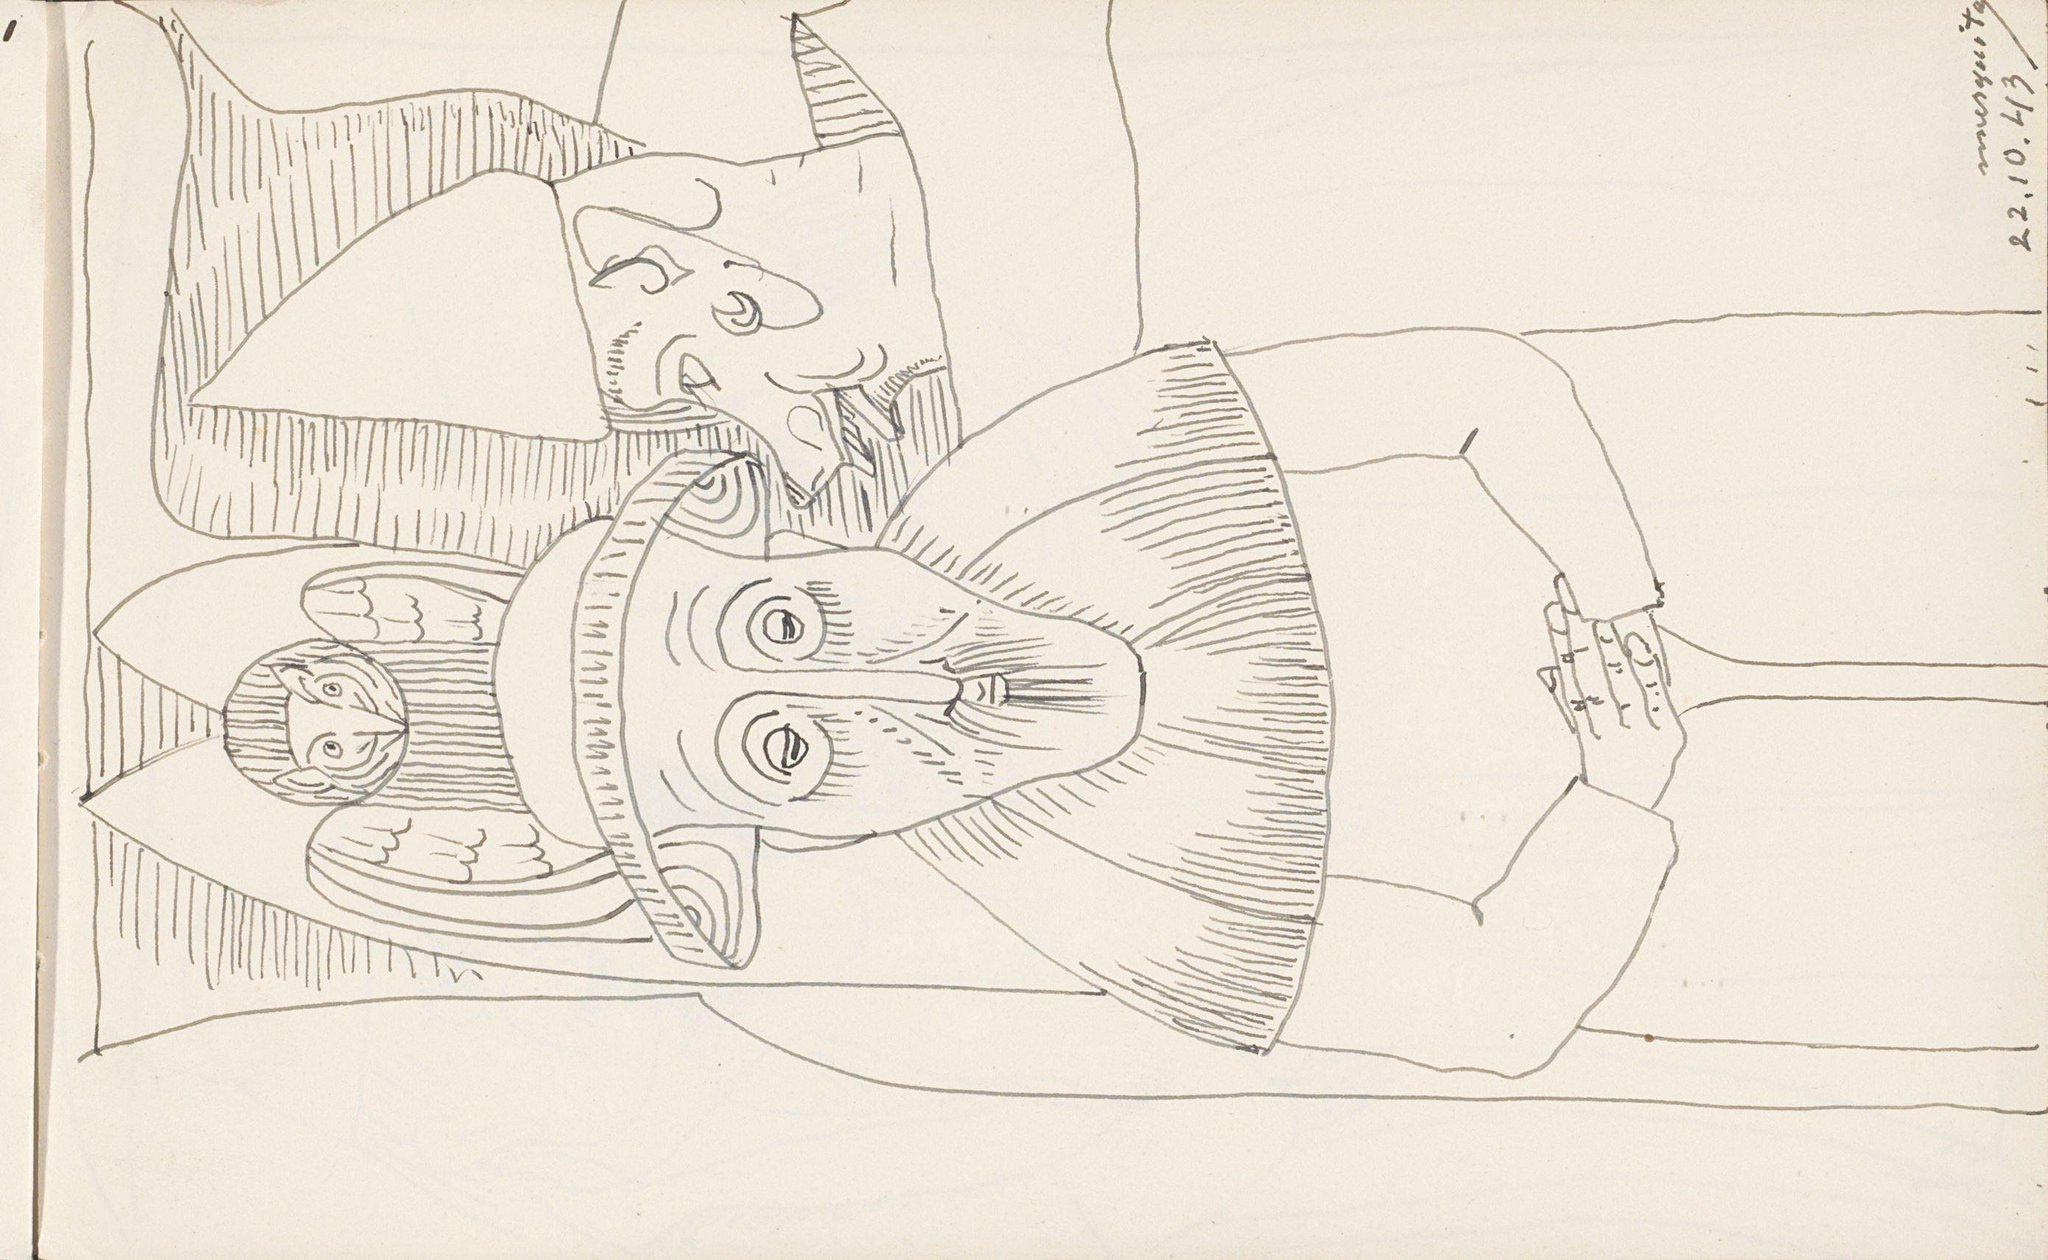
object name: sketchbook leaf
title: Man met een snor en aureool, de handen gevouwen over een wandelstok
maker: samuel jessurun de mesquita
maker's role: draughtsman, print maker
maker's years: 1868-1944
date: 1943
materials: ink, paper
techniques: pen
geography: amsterdam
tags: nimbus, halo ~ radiance emanating from persons or things, walking-stick, staff, adult man, owls, hands folded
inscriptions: signature and date: ‘mesquita/ 22.10.43’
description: Boven het hoofd van de man, die een lange mantel draagt, staat een uil. Rechts een fantasiefiguur met een puntmuts in profiel naar links. Blad 15 recto uit een schetsboek met 18 bladen.